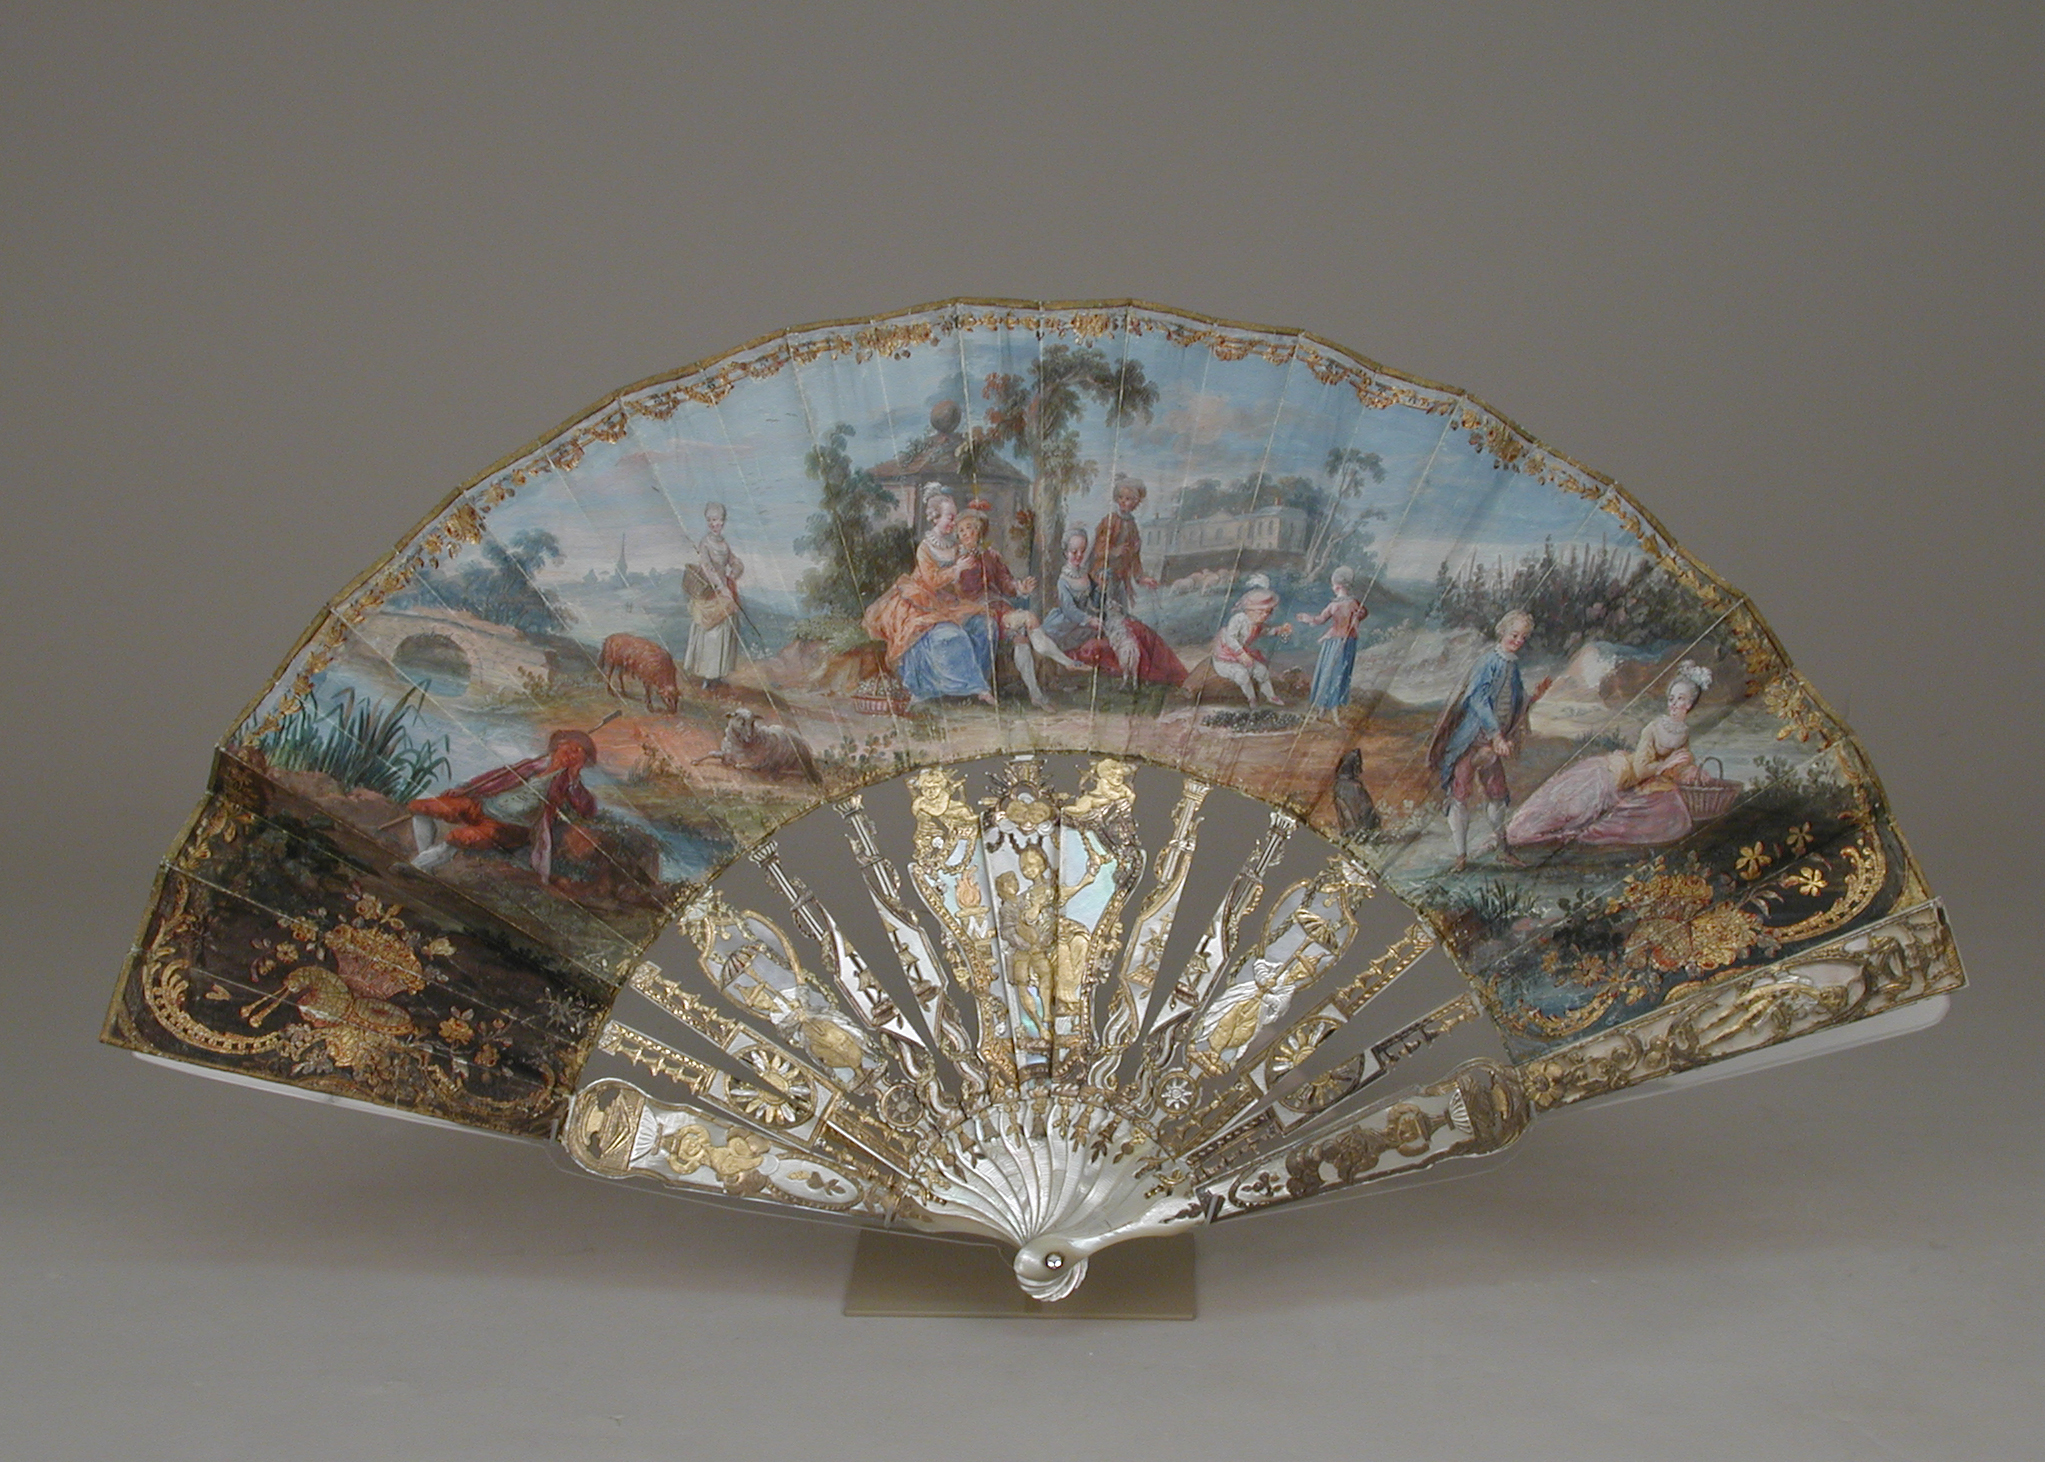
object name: fan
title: Folding fan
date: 1734-1766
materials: ivory, mother of pearl, paper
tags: men,women,sheep